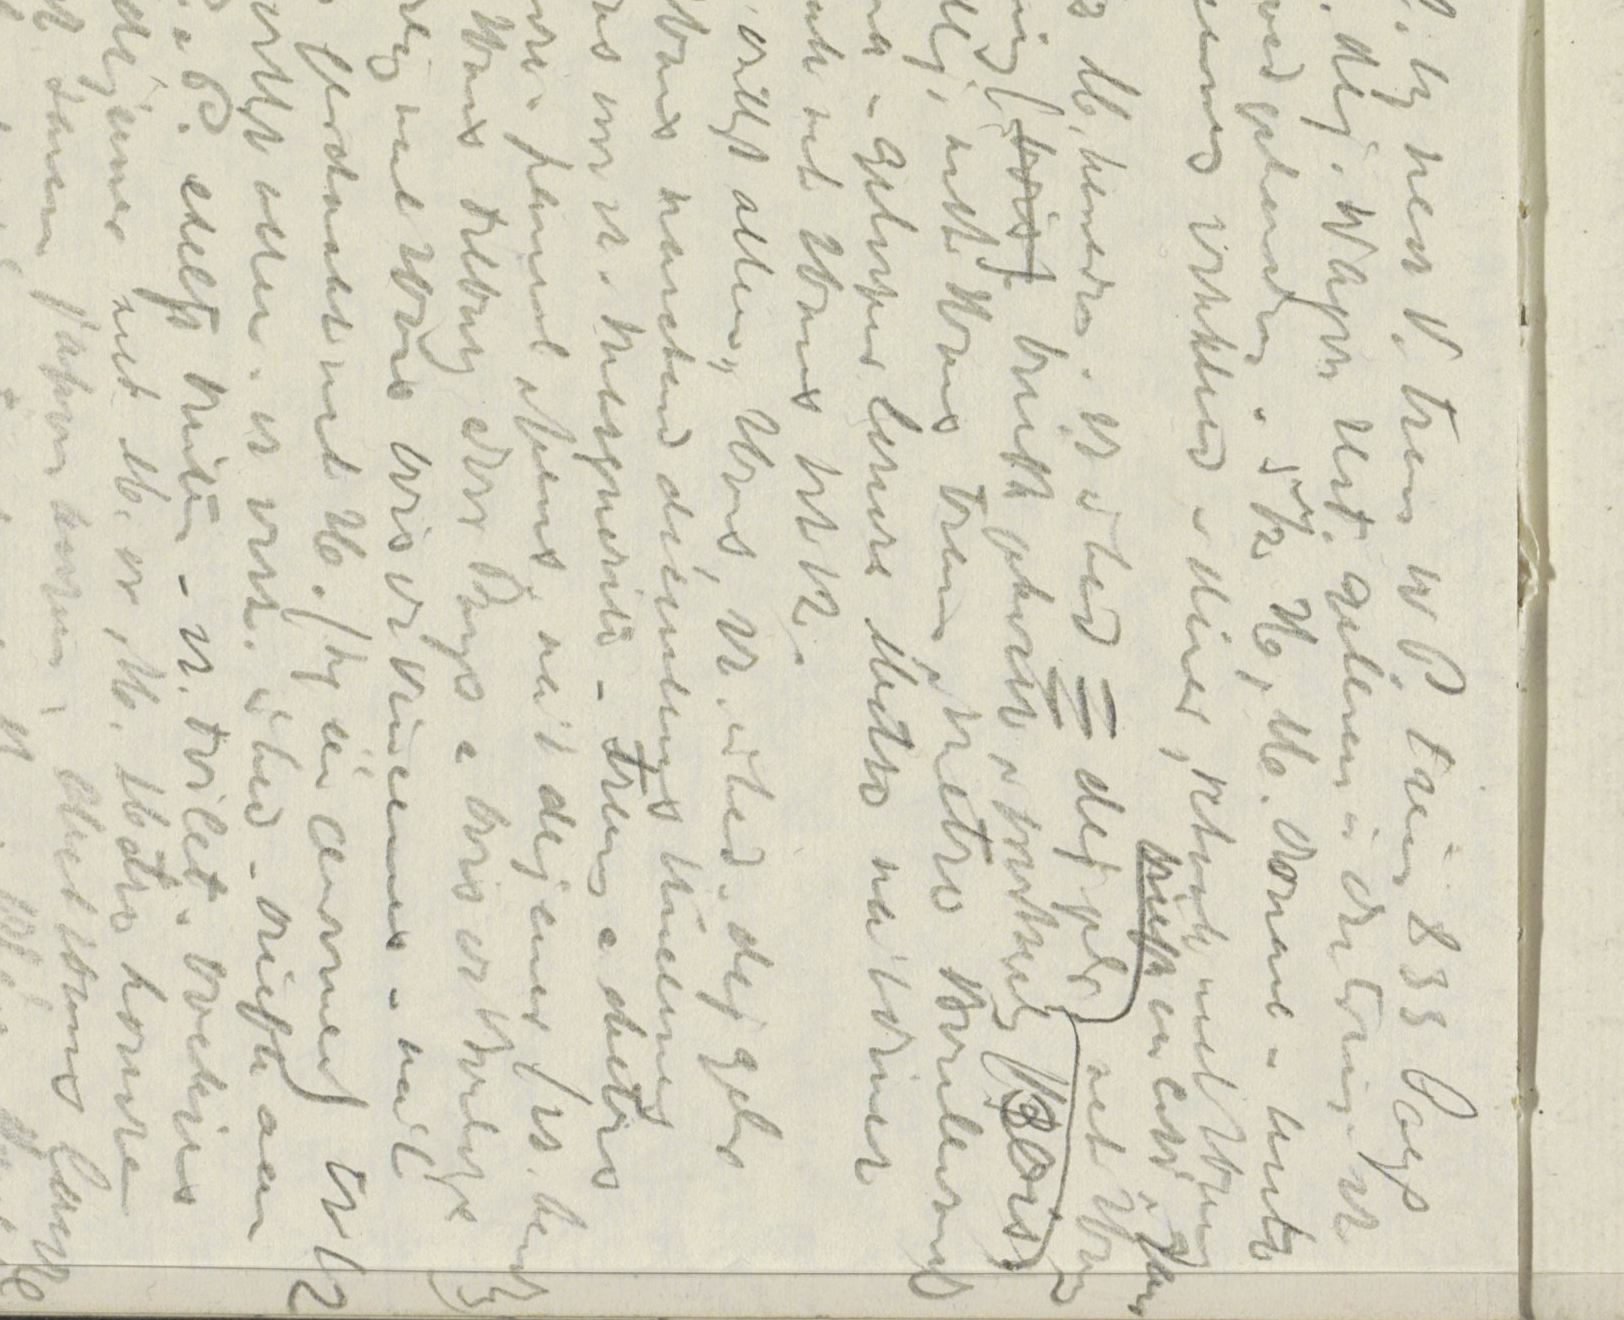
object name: sketchbook leaf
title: Dagboeknotities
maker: willem witsen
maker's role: draughtsman, painter, print maker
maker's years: 1860-1923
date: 1915-1921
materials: paper, pencil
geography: northern france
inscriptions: annotation: ‘[...]’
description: Mogelijk (deels) van de huwelijksreis van Witsen naar Noord-Frankrijk in 1893. Blad 14 verso uit een schetsboek met 23 bladen.